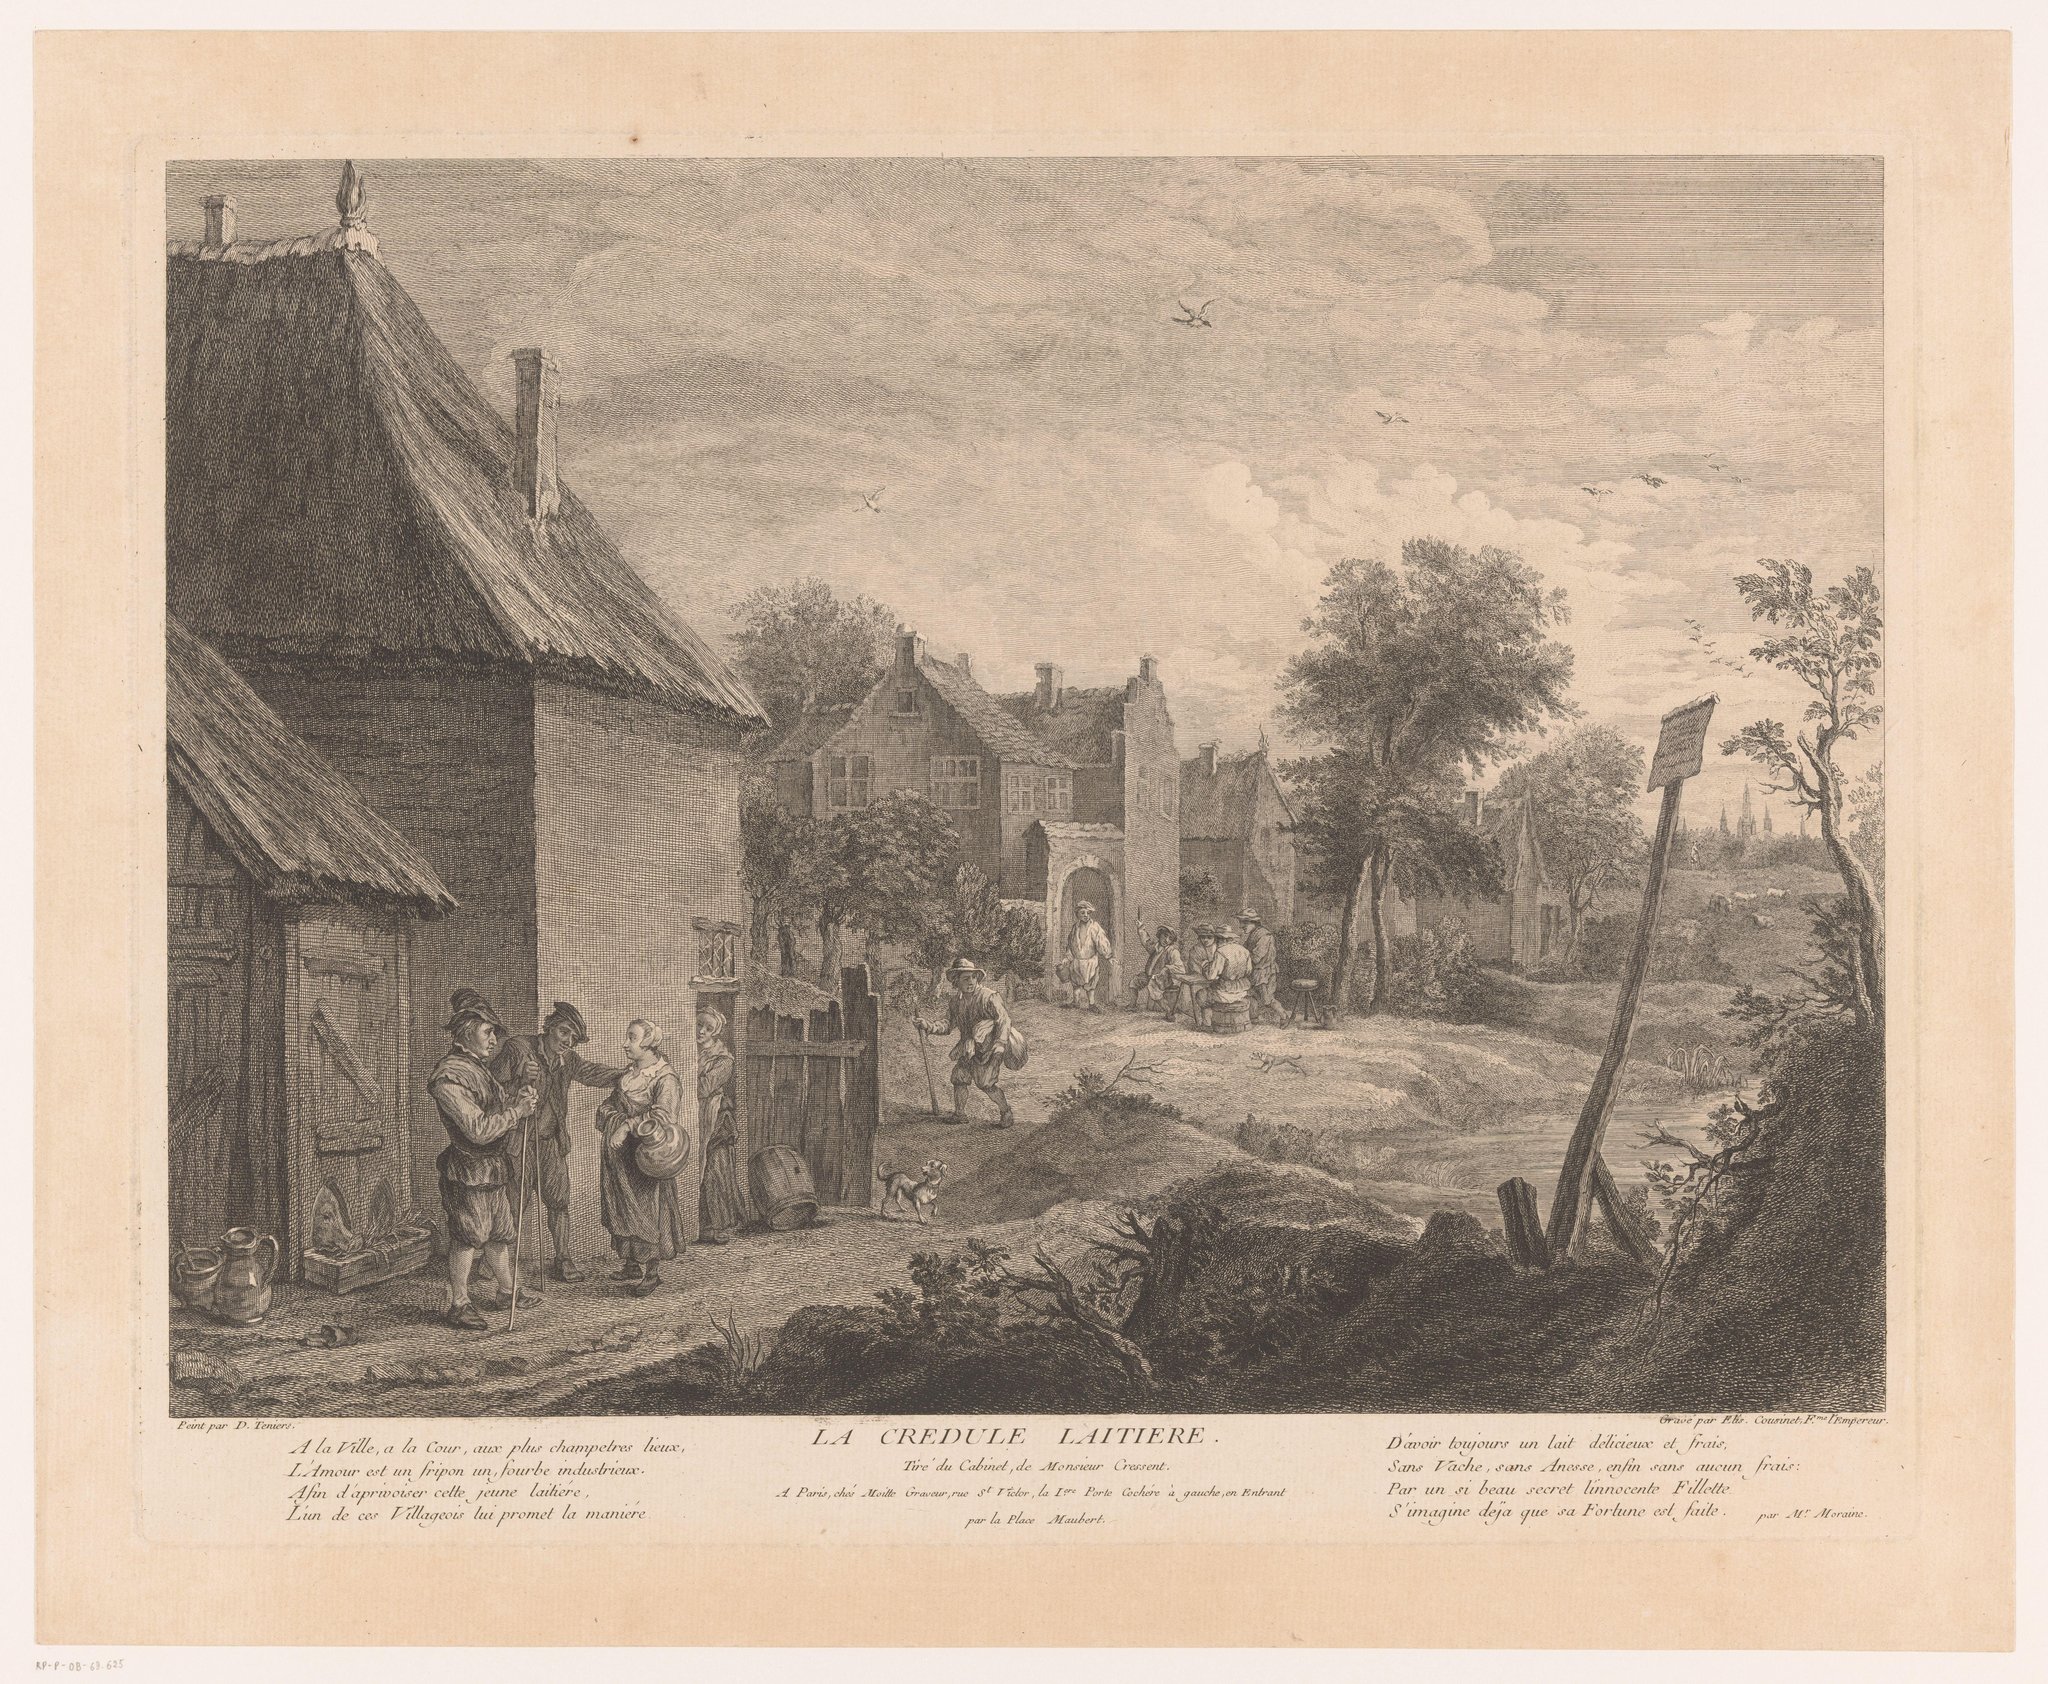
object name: print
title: Reizigers met ezels en hoefsmid bij een smederij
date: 1758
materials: paper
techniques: engraving, etching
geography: paris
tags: farrier, shoeing-smith, ass, donkey, 'en route', traveller under way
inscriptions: collector's mark: Lugt 240